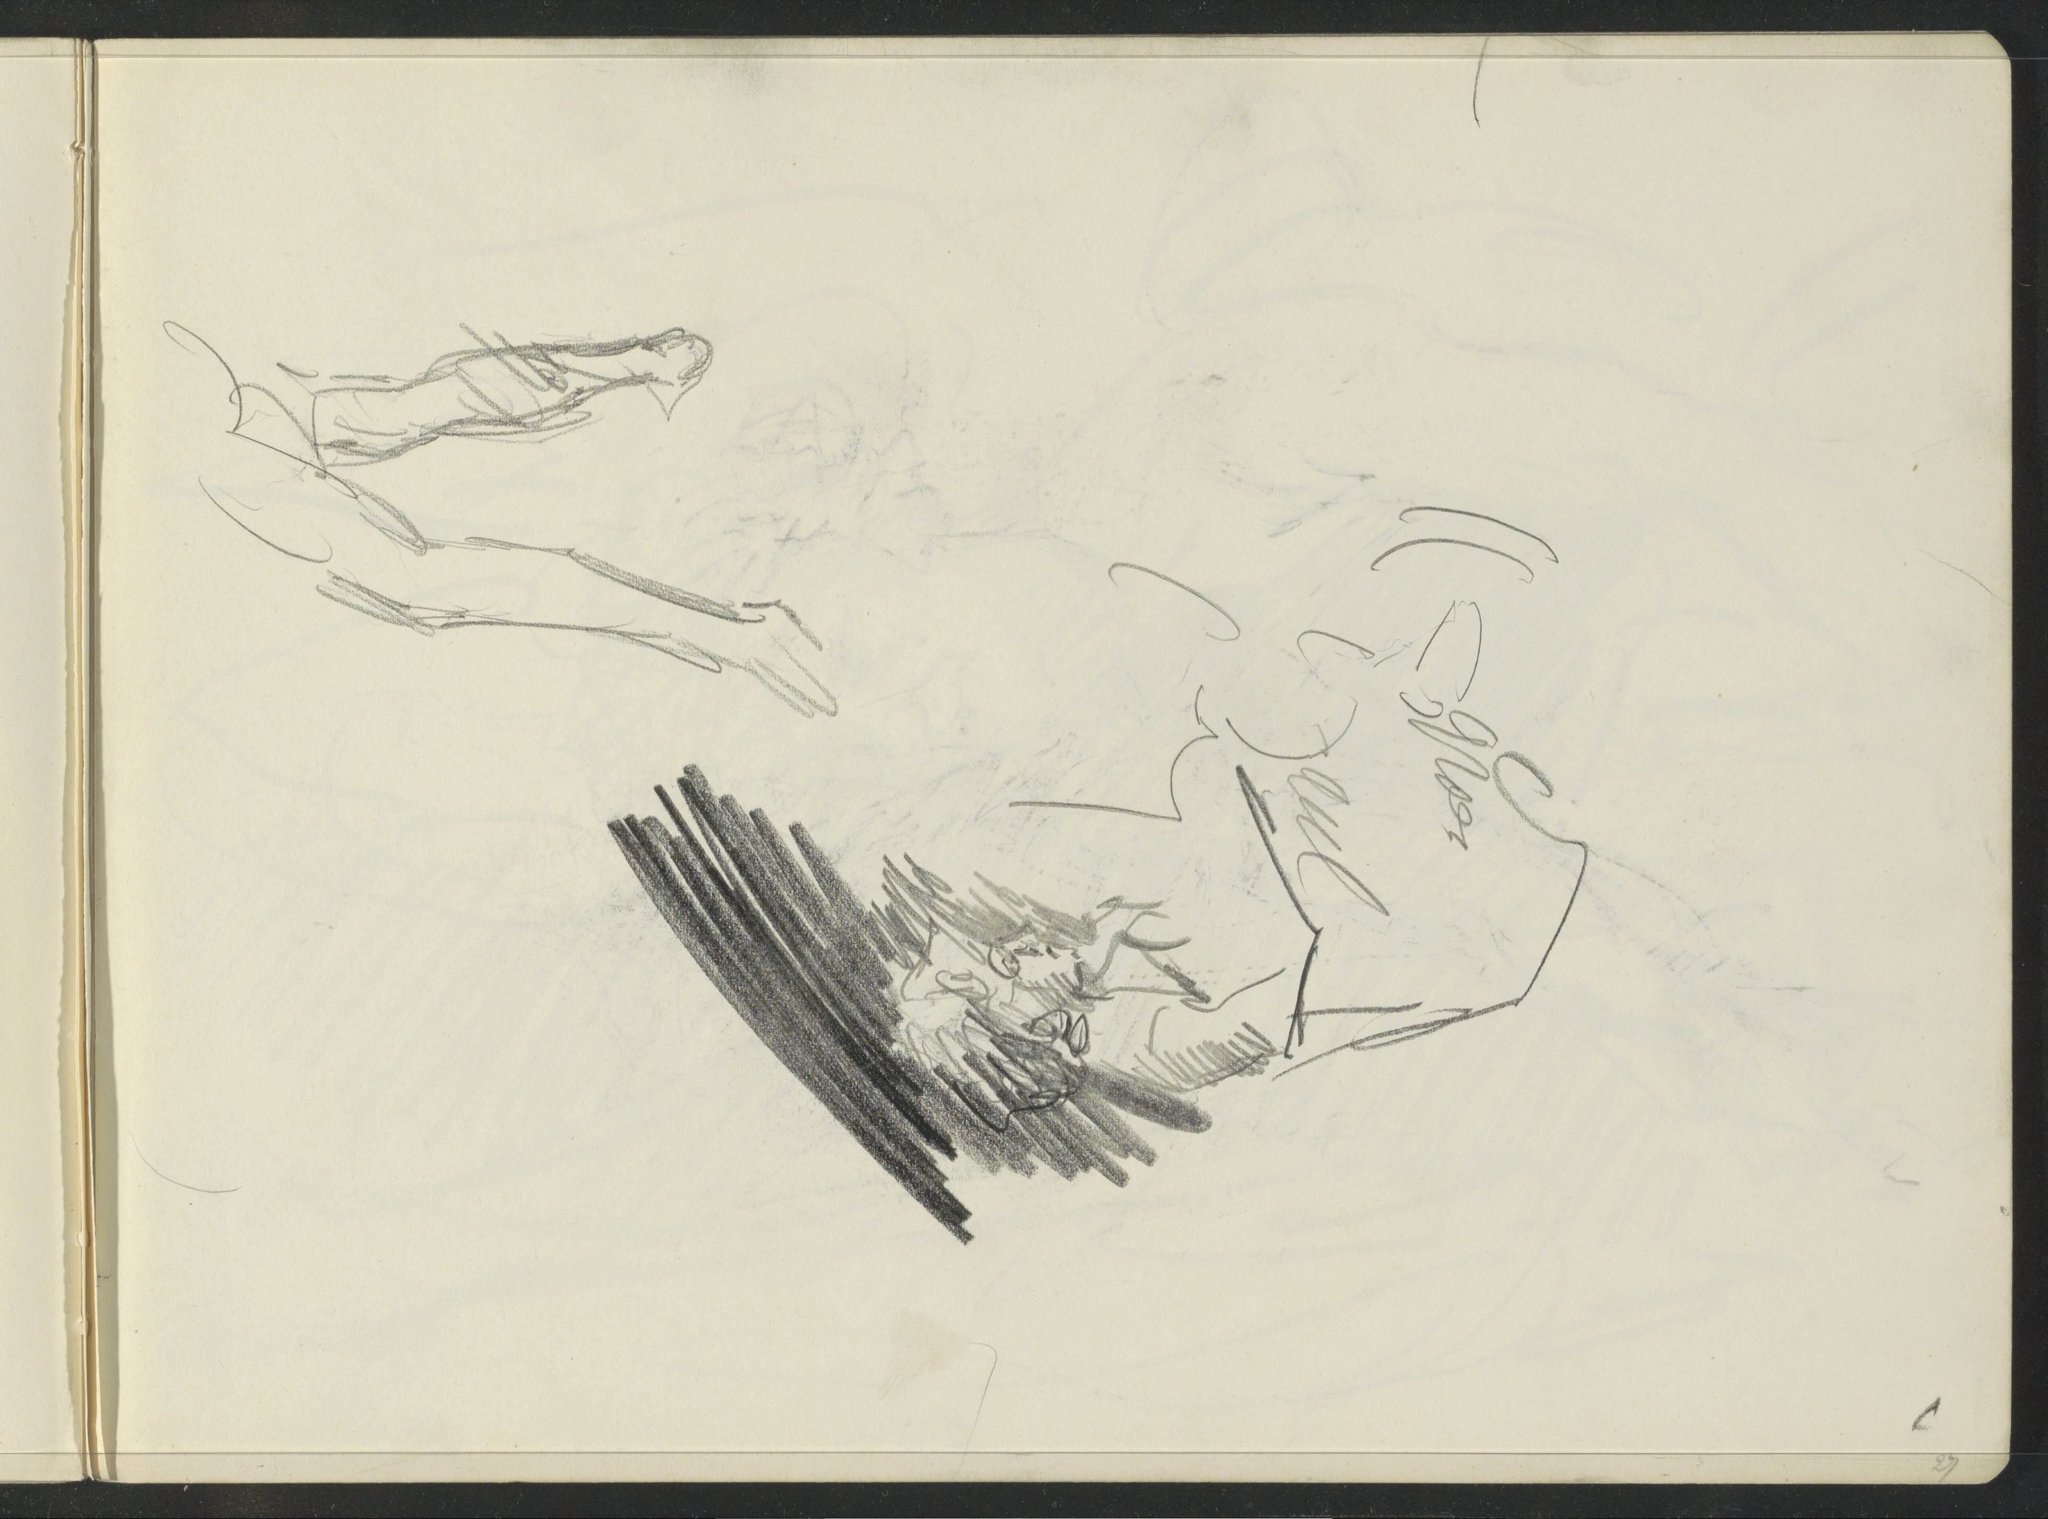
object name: sketchbook leaf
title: Studieblad met benen en een zittende vrouw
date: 1915-1934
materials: paper, pencil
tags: legs, adult woman (+ sitting)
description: Blad 27 recto uit schetsboek XVI met 32 bladen.